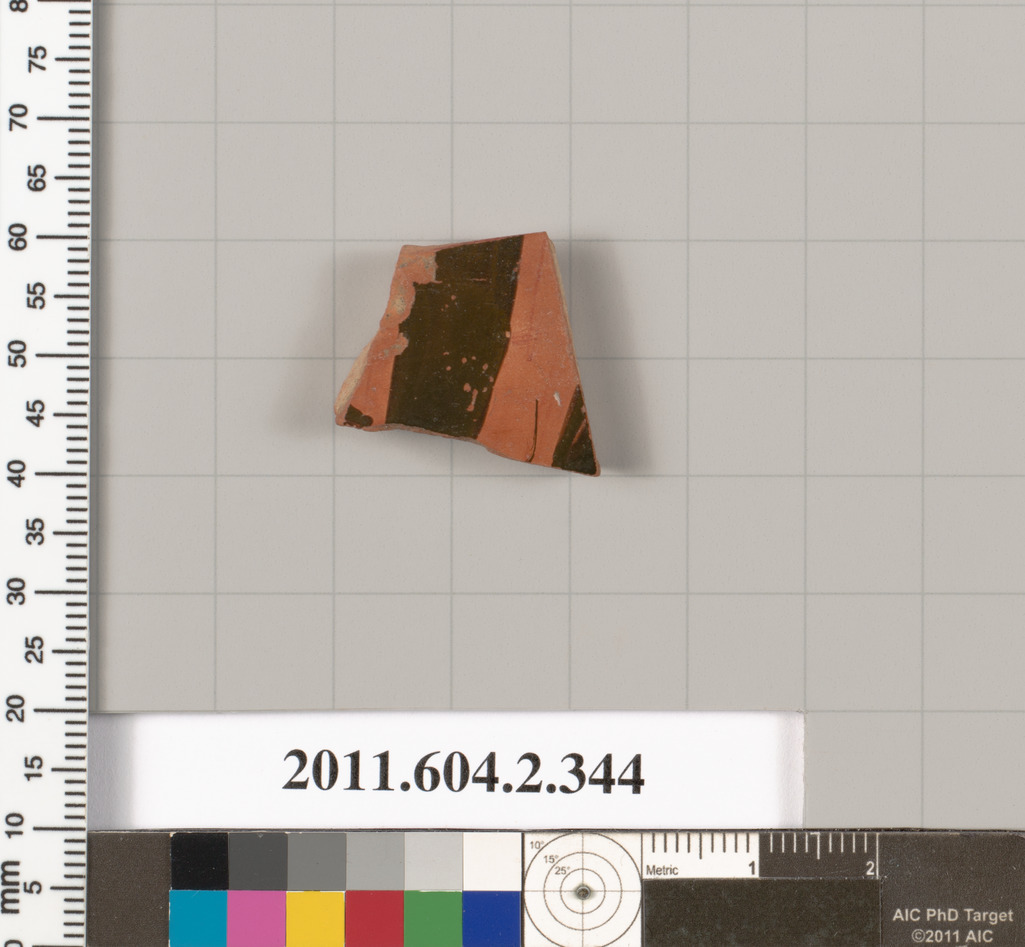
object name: column krater fragment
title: Terracotta fragment of a column-krater (bowl for mixing wine and water)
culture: greek, attic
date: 460-440 BCE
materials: terracotta